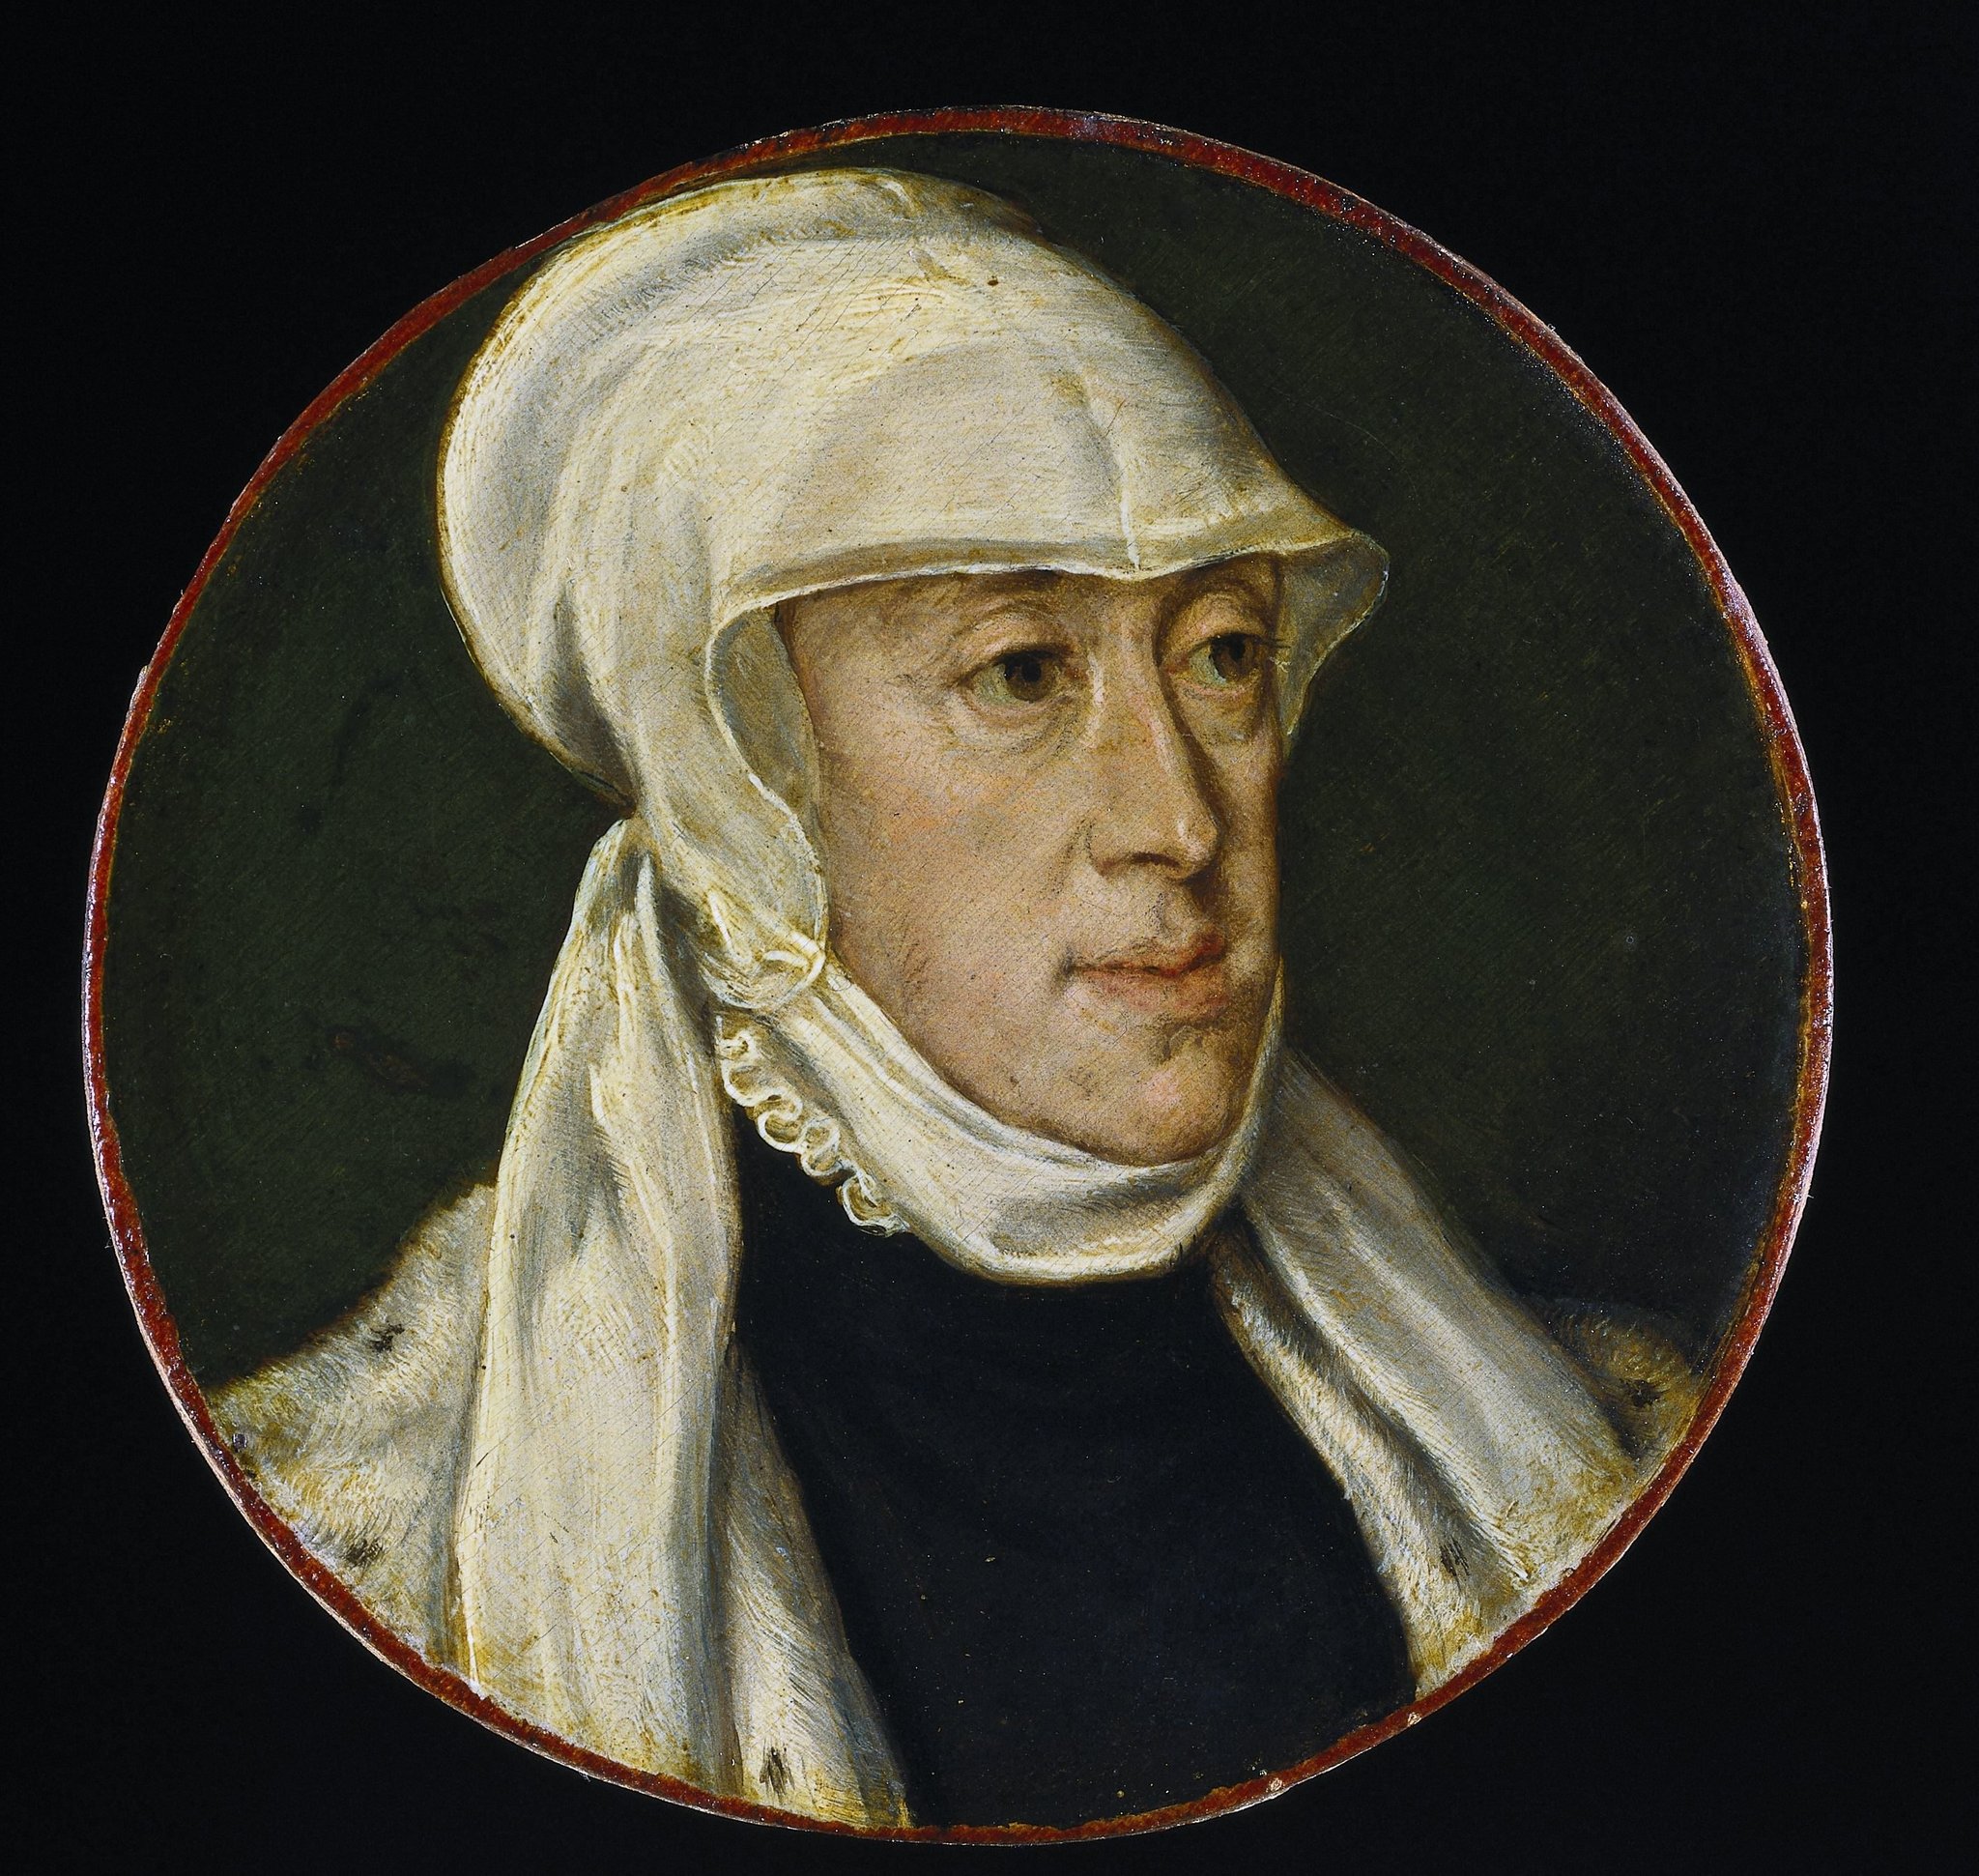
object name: painting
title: Maria of Hungary, Regent of the Netherlands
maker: Anonymous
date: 1550-1560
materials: oil, panel, wood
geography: low countries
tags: brussels, maria van hongarije (landvoogdes der nederlanden), historical persons - bb - woman (+ head (and shoulders) (portrait)), netherlands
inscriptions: inscription: ‘Marie par la grace de dieu rogne de hongrie de hol ... n Soeur de l'empereur Charles 5, qui fut gouvernante des Pays-Bas’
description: Maria van Hongarije, 1505-1558, landvoogdes der Nederlanden, 1531-1555. Vermoedelijk een copie naar een verloren portret door Titiaan. Omstreeks 1550. Deze jongere zuster van Karel V volgde in 1531 Margaretha van Oostenrijk op als landvoogdes. Toen Karel V in 1555 afstand deed trok ook Maria zich terug. Maria van Hongarije bezat een belangrijke verzameling schilderijen. Zij kende Titiaan, die portretten van haar en haar familieleden maakte.